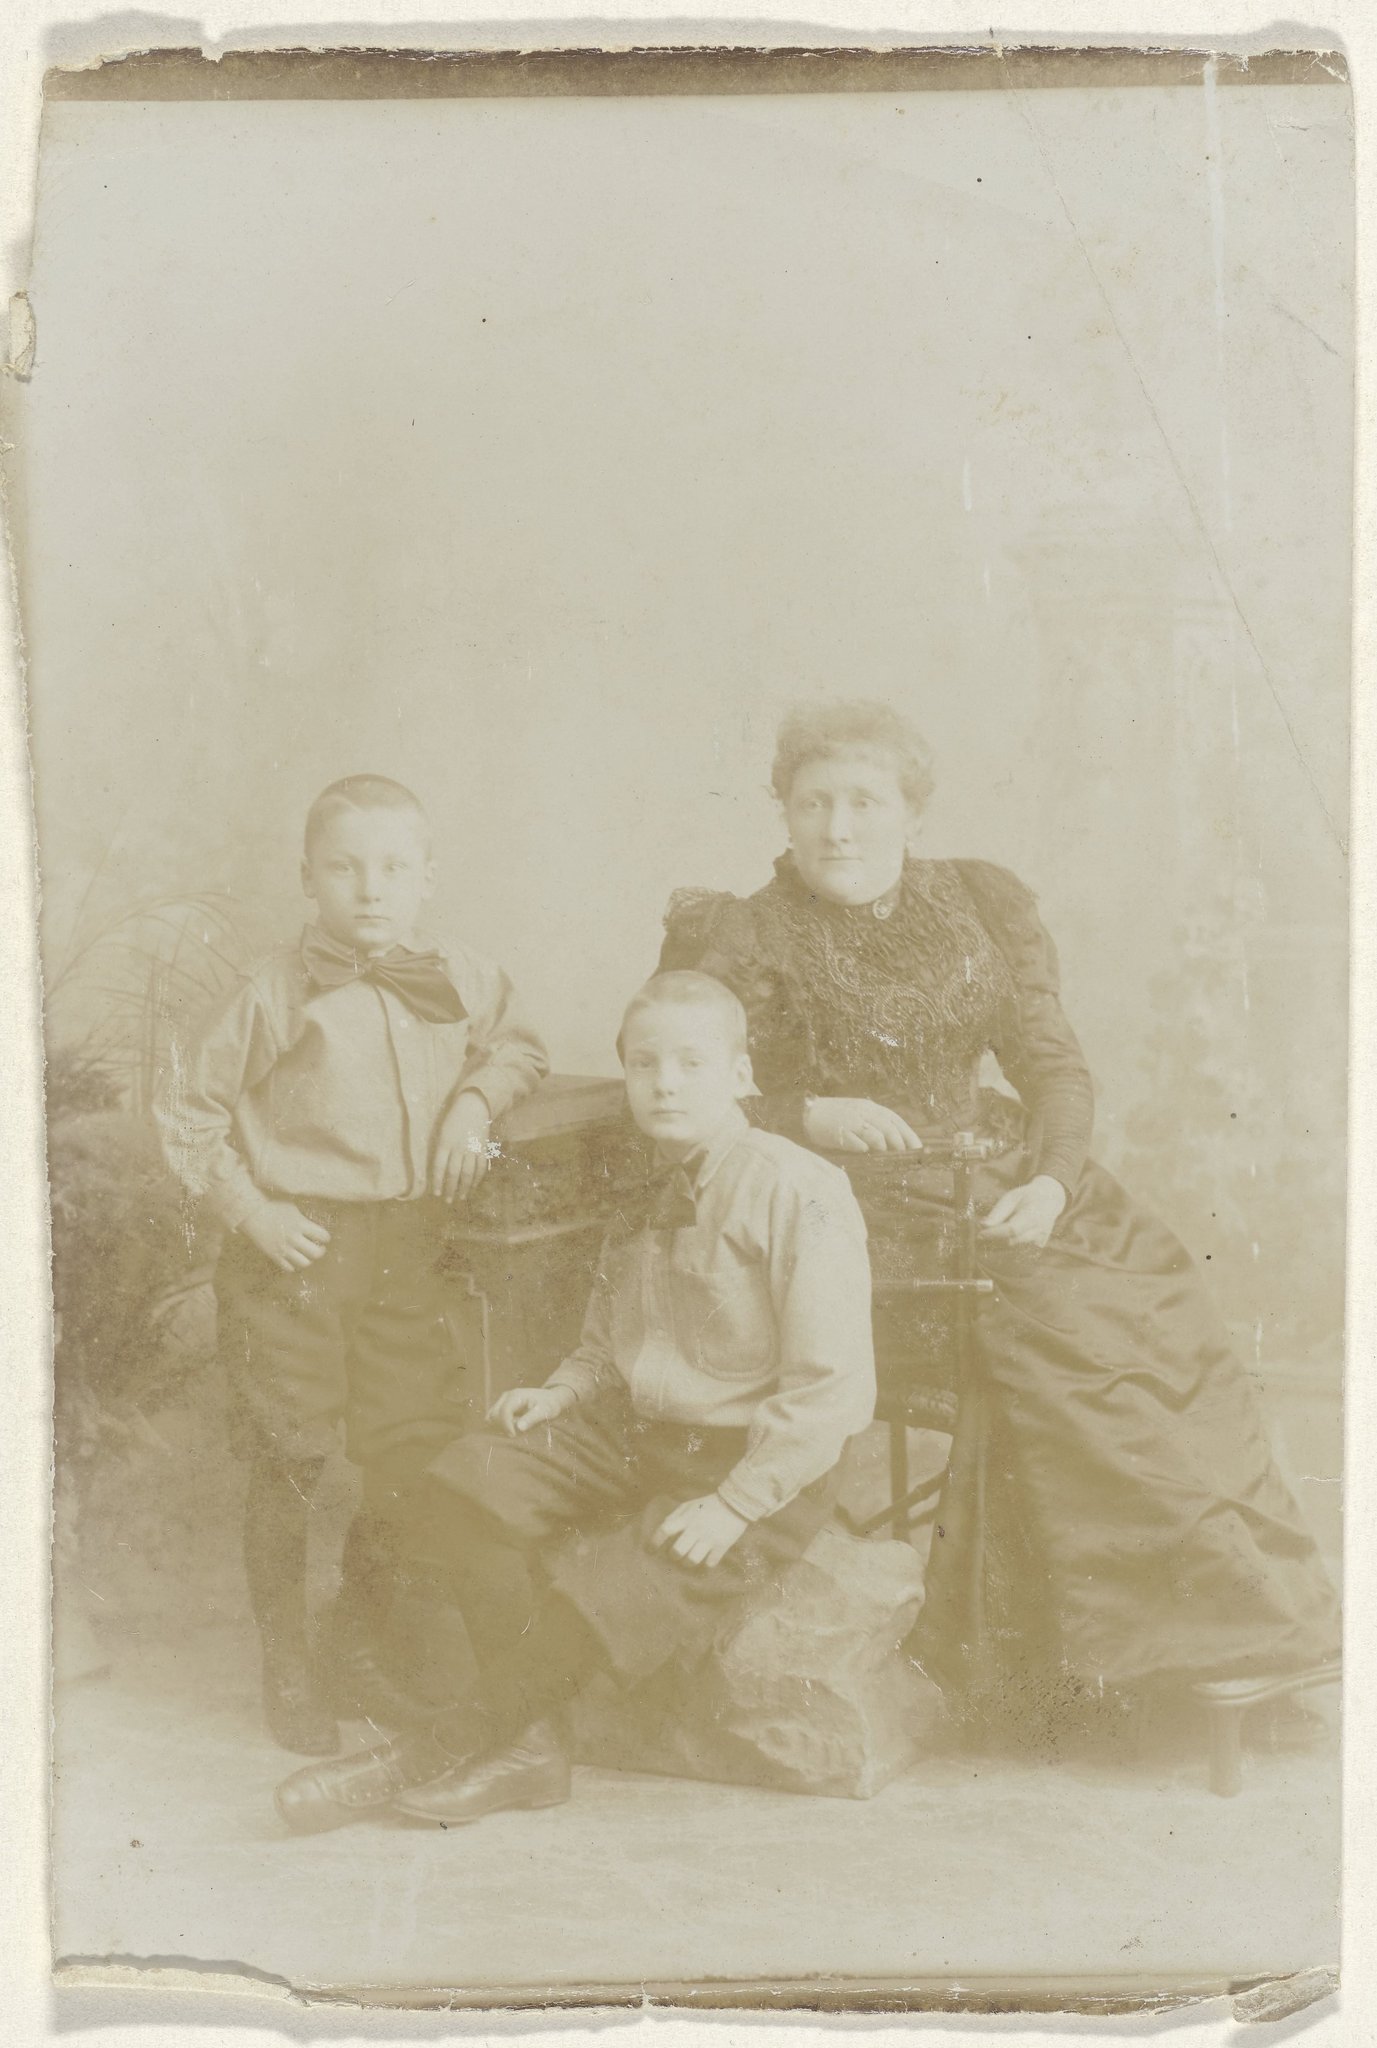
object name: photograph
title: Groepsportret van Grietje, David en Bram Vermeulen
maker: cornelis johannes lodewicus vermeulen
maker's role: fotograaf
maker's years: 1861-1936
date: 1890-1895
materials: photographic support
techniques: albumen print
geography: the hague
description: Grietje Vermeulen met de twee kinderen Bram en David, beide in korte broek en met grote strik voor